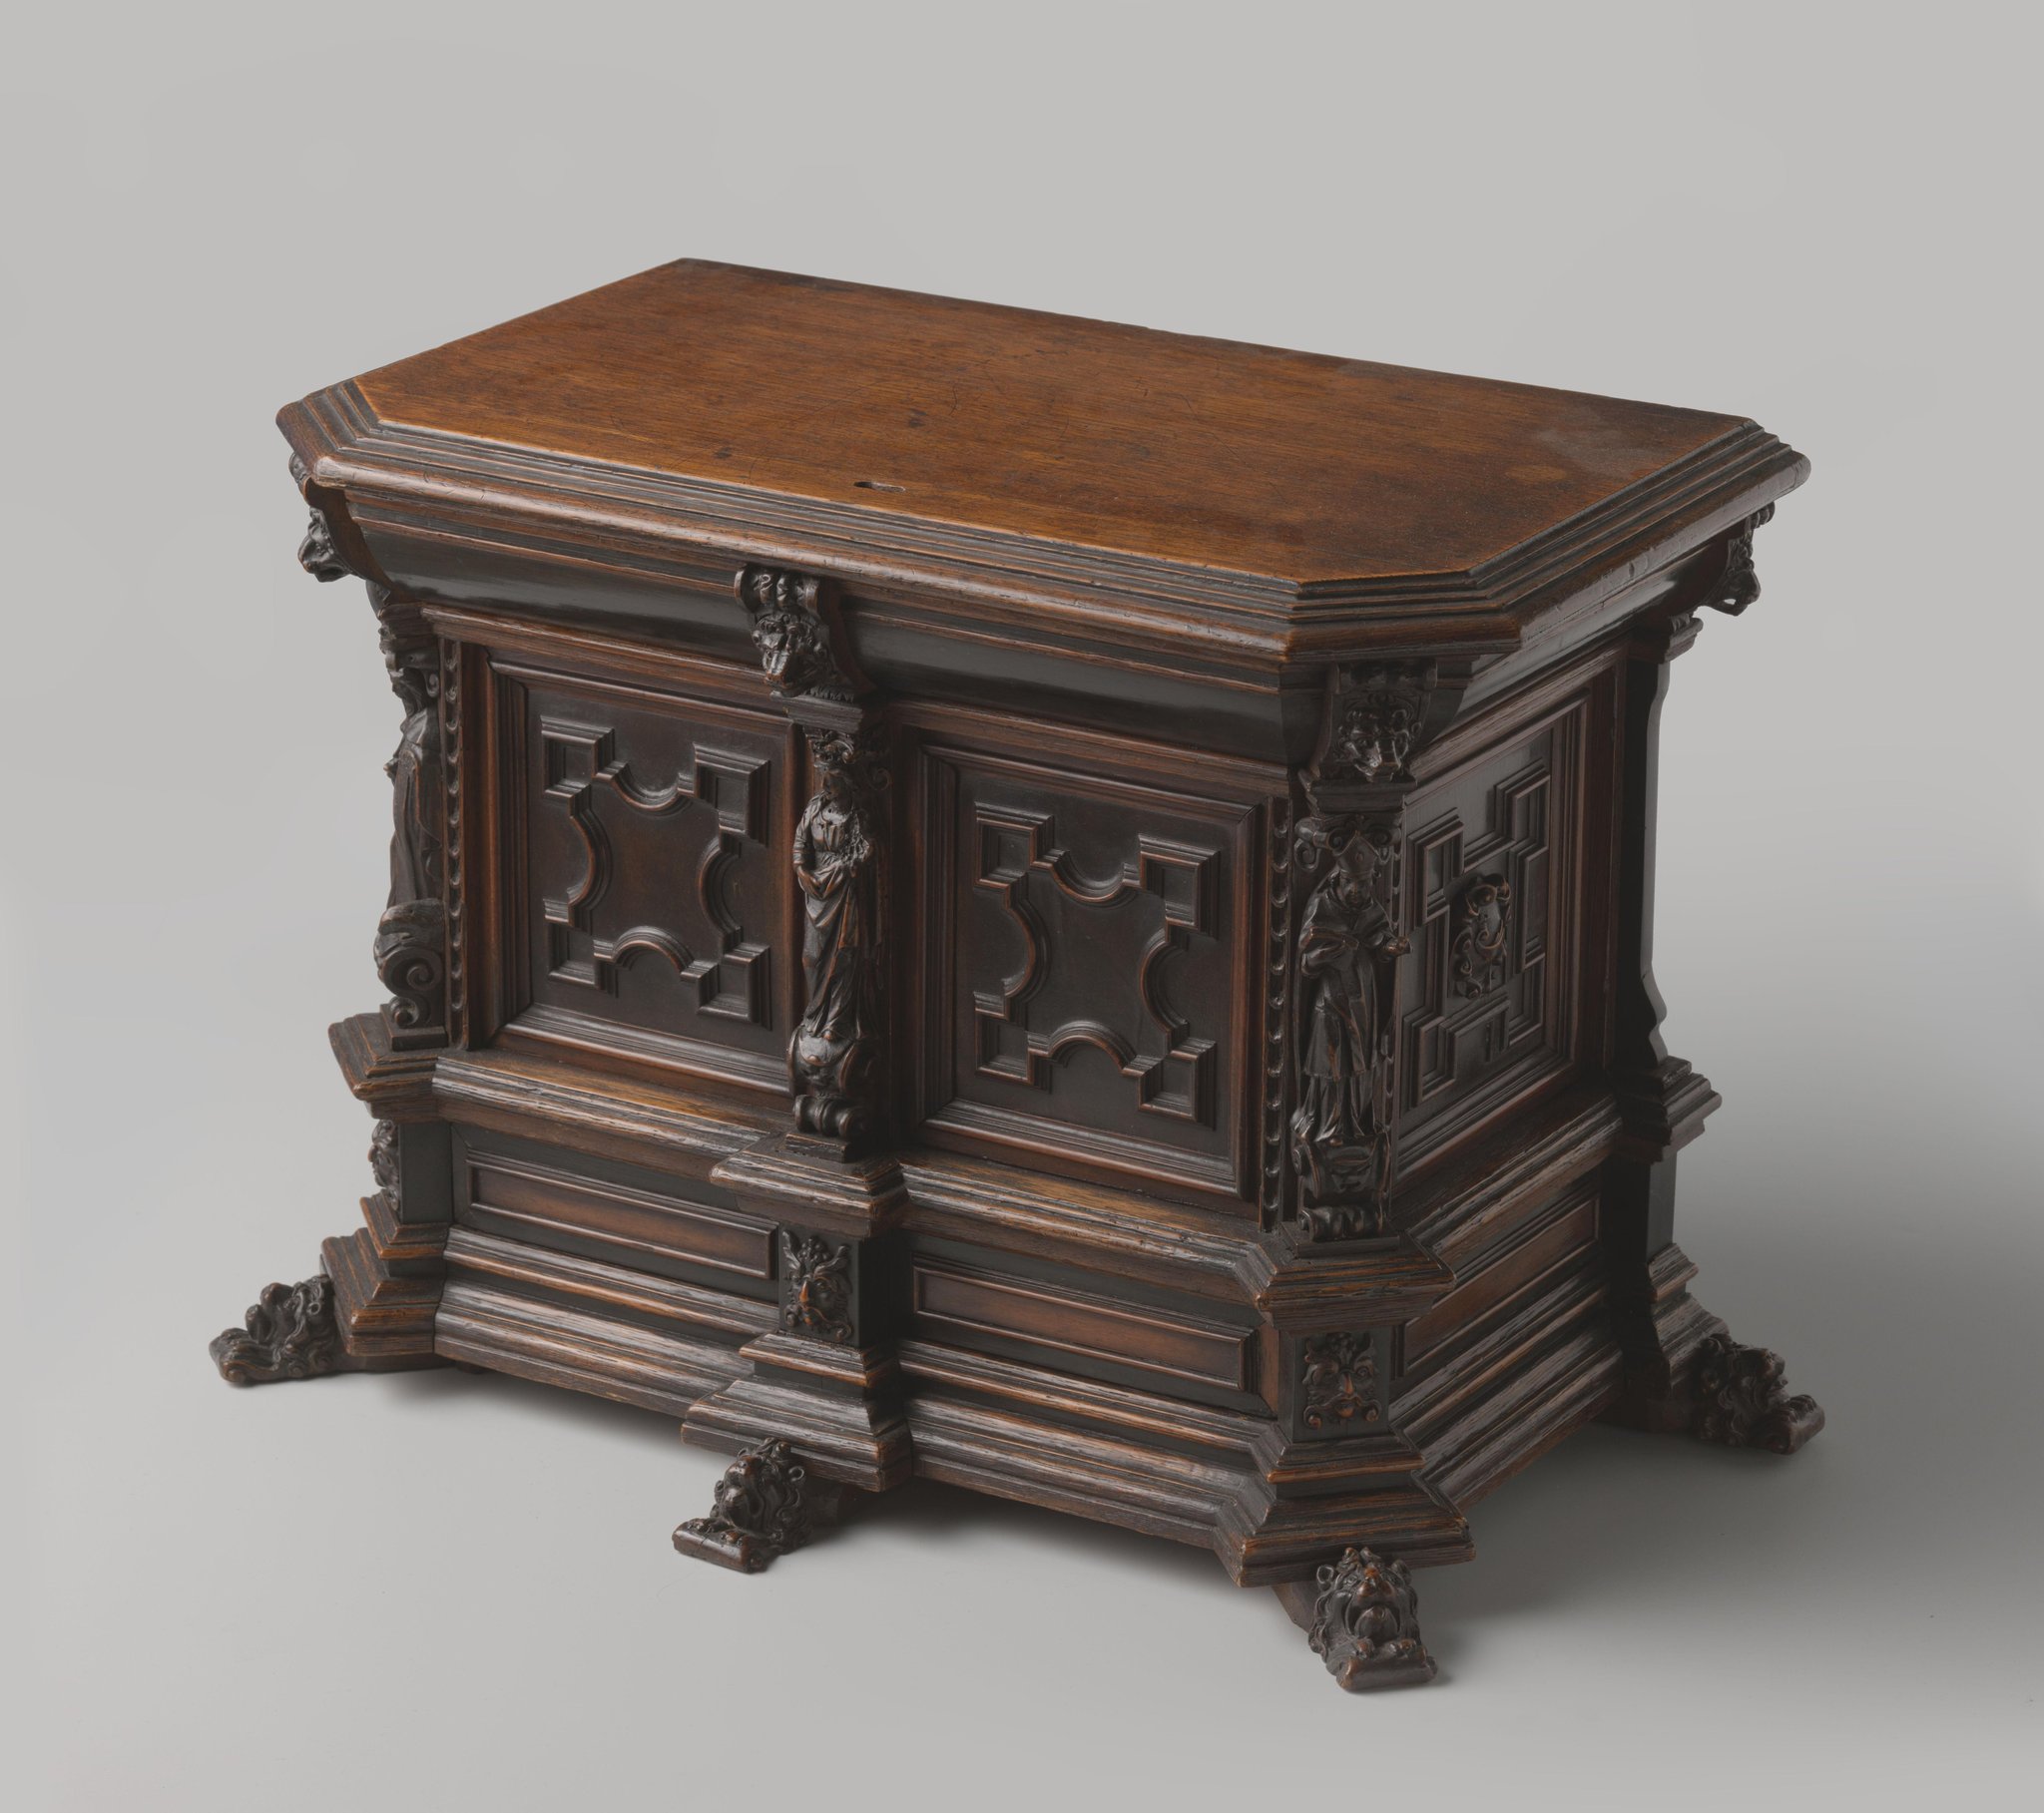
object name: case furniture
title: Kist versierd met atlanten in de gedaante van Antonius abt met varken en een bisschop met boek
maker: Anonymous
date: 1650-1700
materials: wood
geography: southern netherlands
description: Gildekist van eikenhout, versierd met ebben- en palmhout. Aan de voorzijde atlanten in de gedaante van Antonius abt met het varken links en een bisschop met een boek rechts. In het midden een vrouwelijke heilige als kariatide. Tussen de stijlen gecorniste panelen. Het voetstuk heeft een schuiflade en rust op voetklossen in de vorm van leeuwen. Aan de linker zijkant binnen een cartouche een passer en aan de rechter een schaaf. Hieruit blijkt dat het kistje gediend heeft voor een timmerlieden- of meubelmakersgilde.